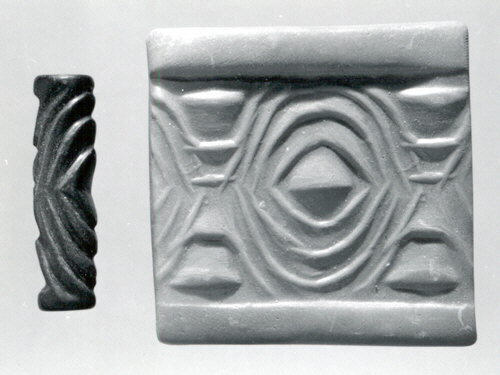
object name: cylinder seal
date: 3100-2900 BCE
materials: mineral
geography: mesopotamia